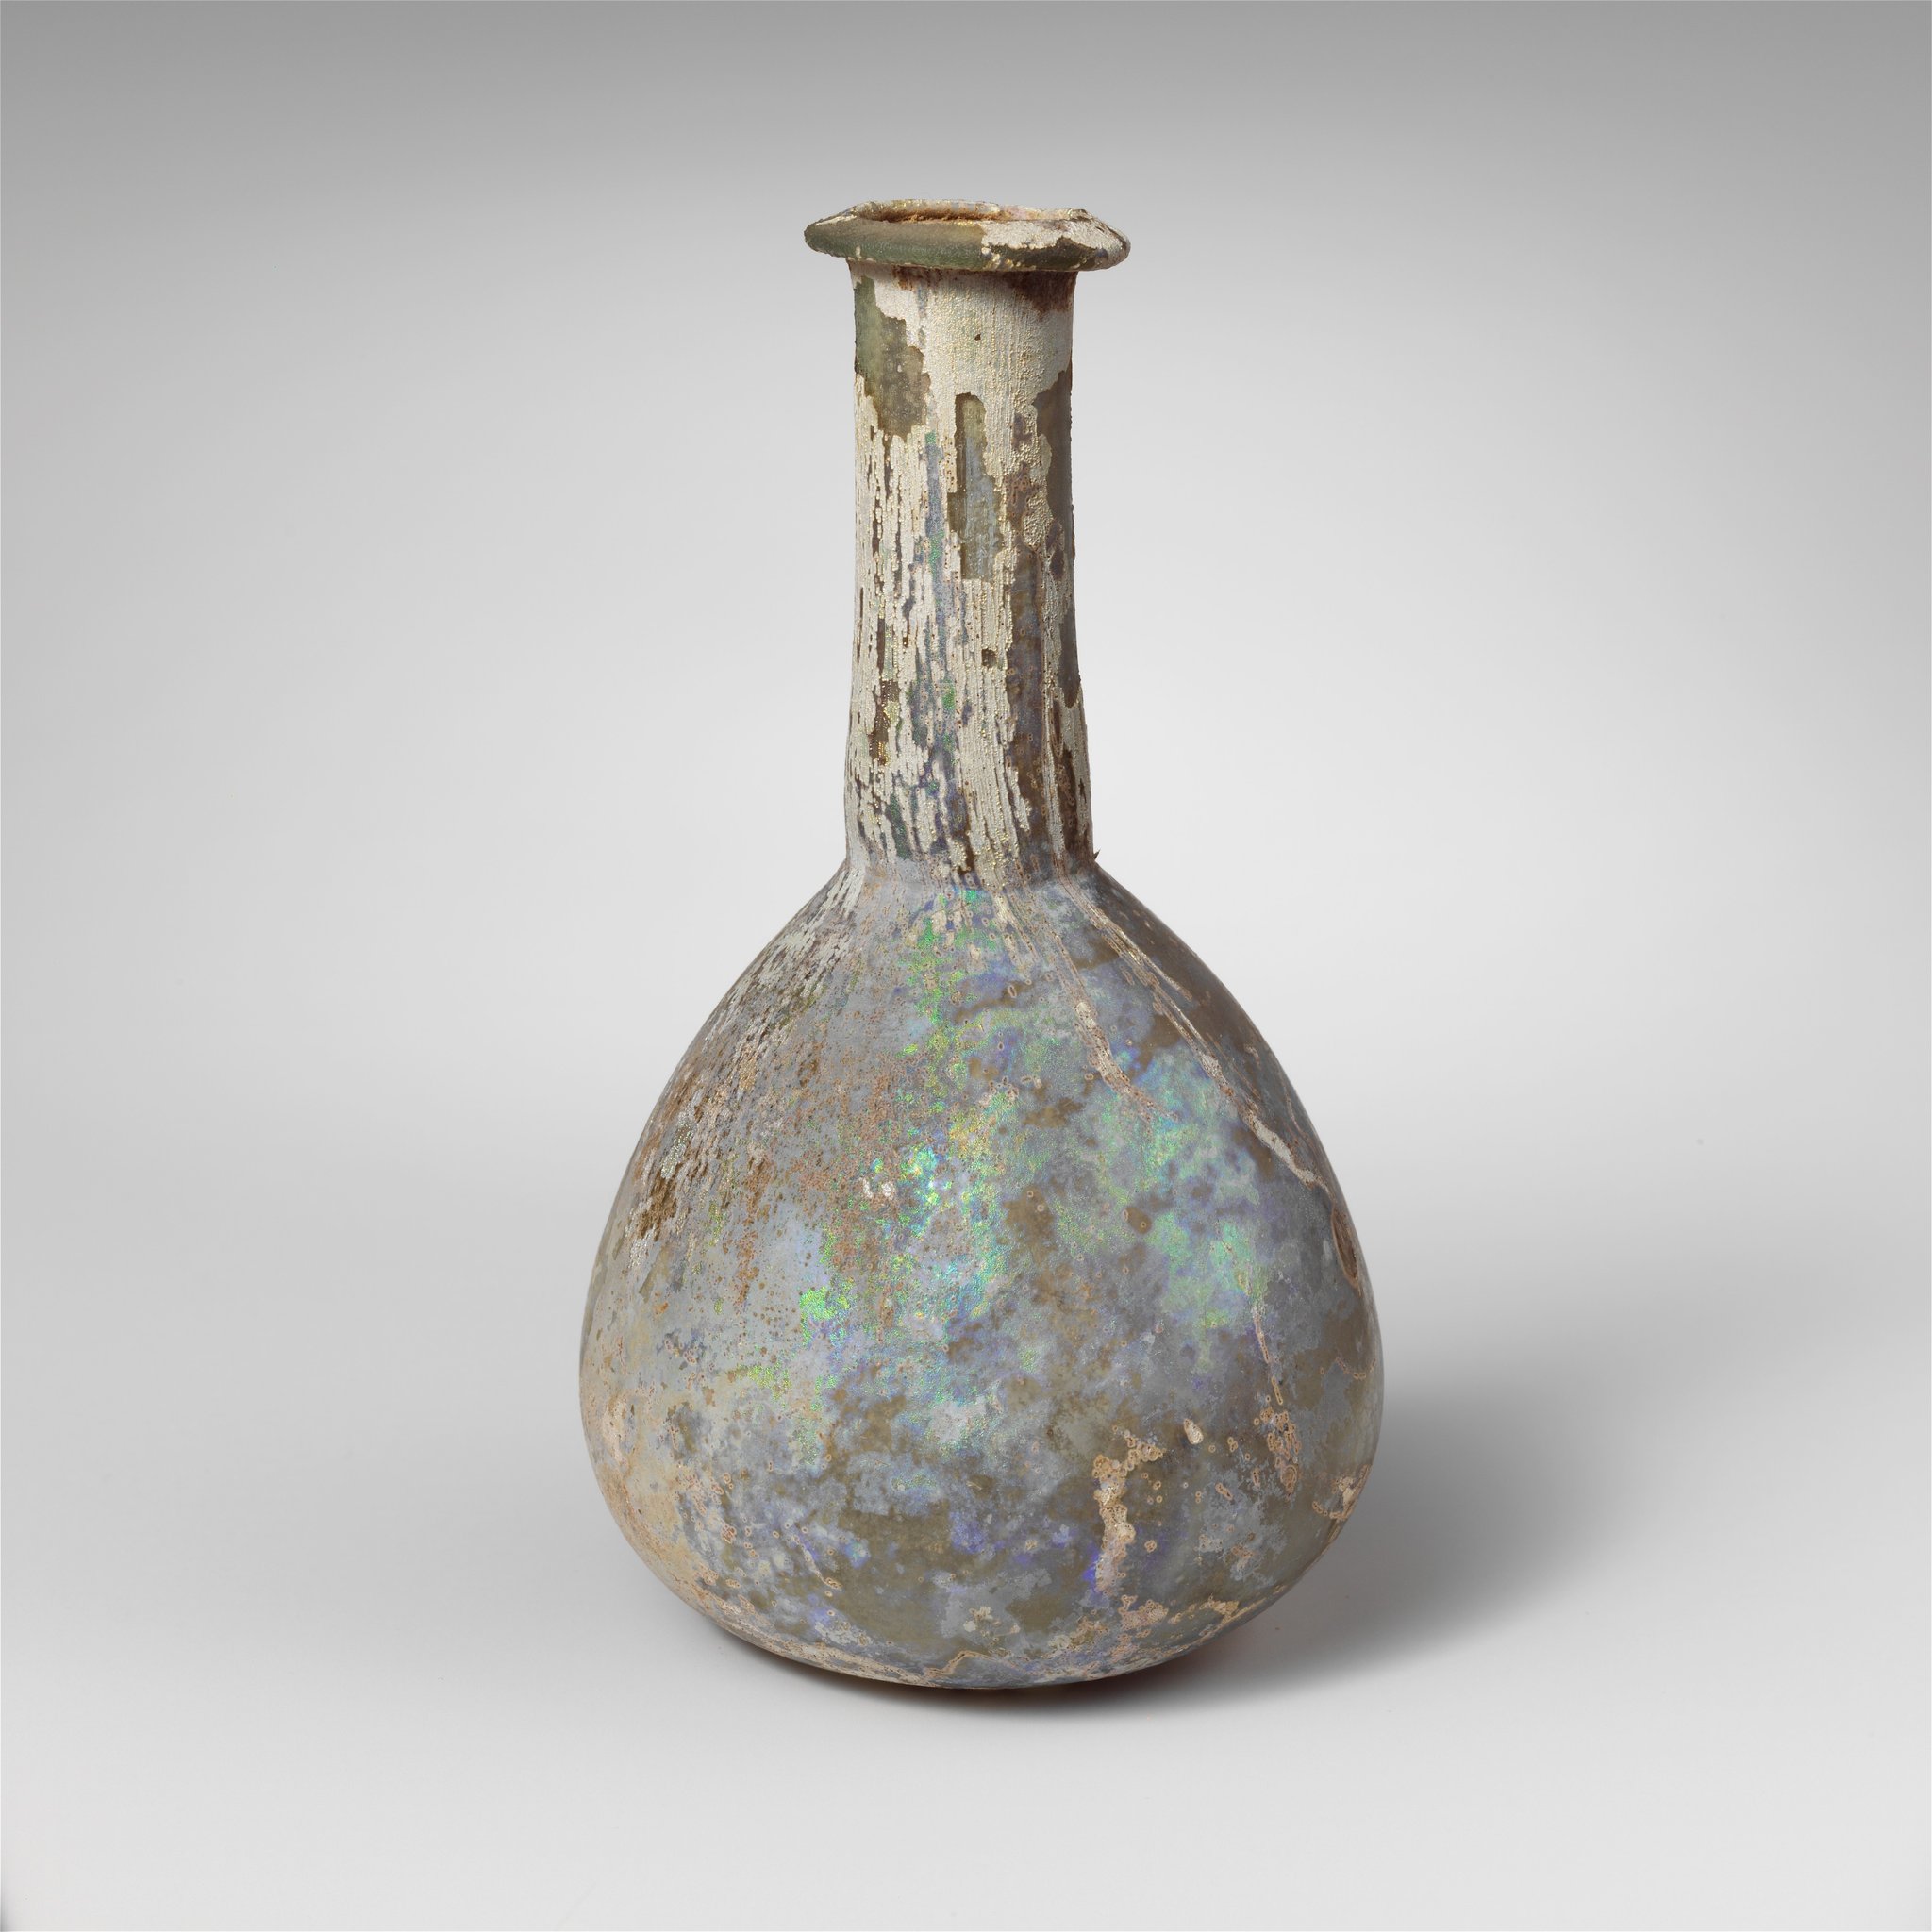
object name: perfume bottle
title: Glass perfume bottle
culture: roman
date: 1-200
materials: glass